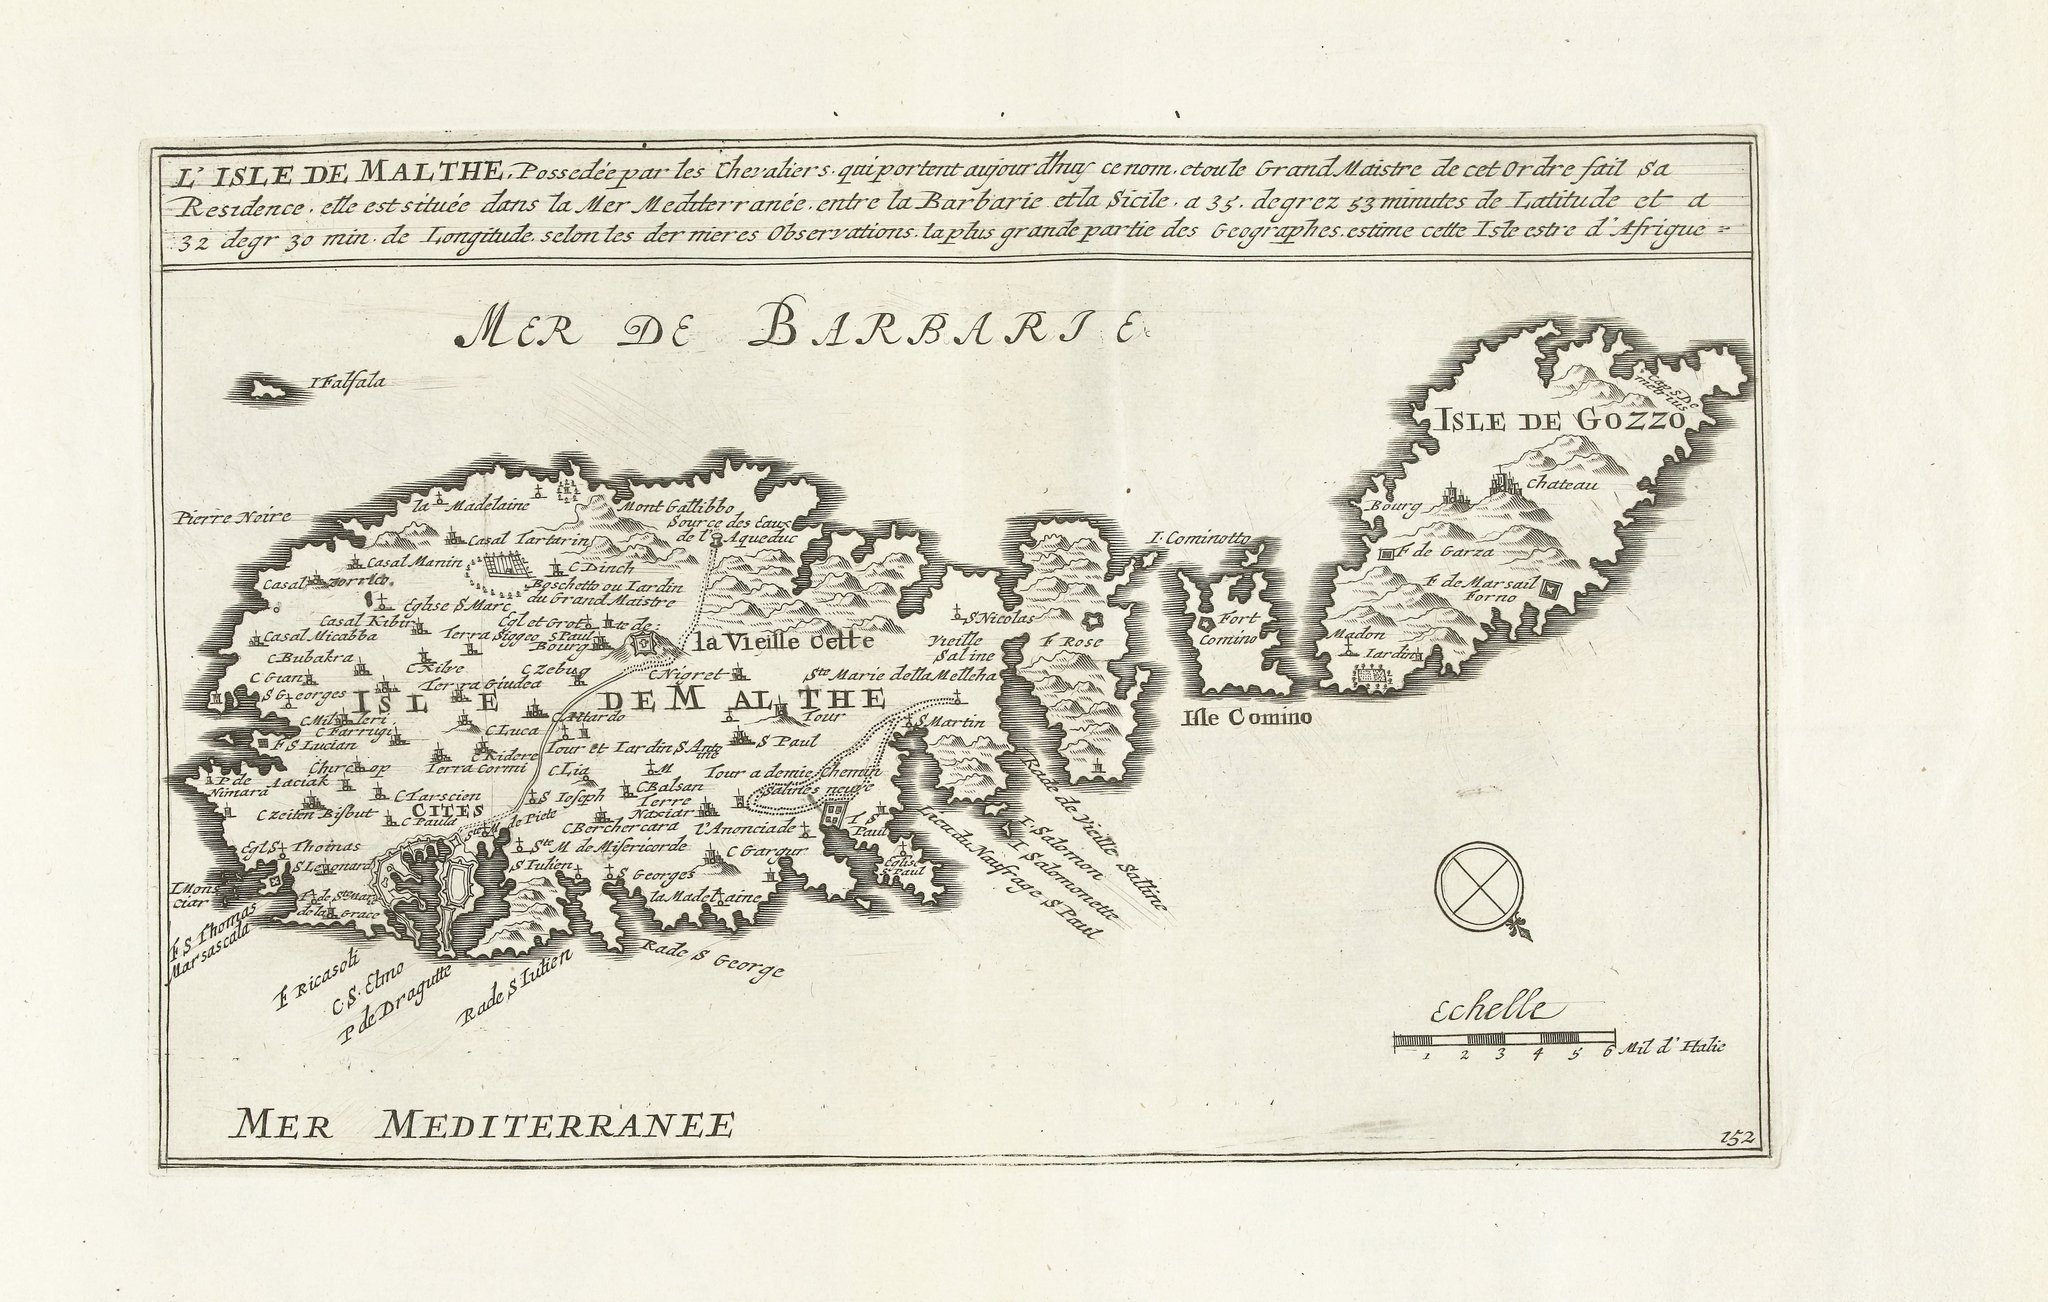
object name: print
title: Les Forces de l'Europe, Asie, Afrique et Amerique, ou description des principales villes avec leurs fortifications. Dessignées par les meilleurs ingenieurs, particulierement celles qui sont sous la domination de la France (...) et ornées de plusieurs superbes edifices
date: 1702-1703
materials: paper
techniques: engraving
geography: amsterdam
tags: maps of separate countries or regions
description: Kaart van het eiland Malta. Plaat nr. 152 in het prentwerk bestaande in totaal uit 276 genummerde platen van vermaarde sterke steden en vestingen in het kader van de Spaanse Successieoorlog. Voor het merendeel zijn deze platen gekopieerd naar de anonieme Franse platen: in Les forces de l'Europe en in: Le theatre de la guerre, dans les Pays-Bas, beide oorspronkelijk uitgegeven door Nicolas de Fer te Parijs (1693-1697) in het kader van de Negenjarige Oorlog. Titel en opschriften in de plaat in het Frans.